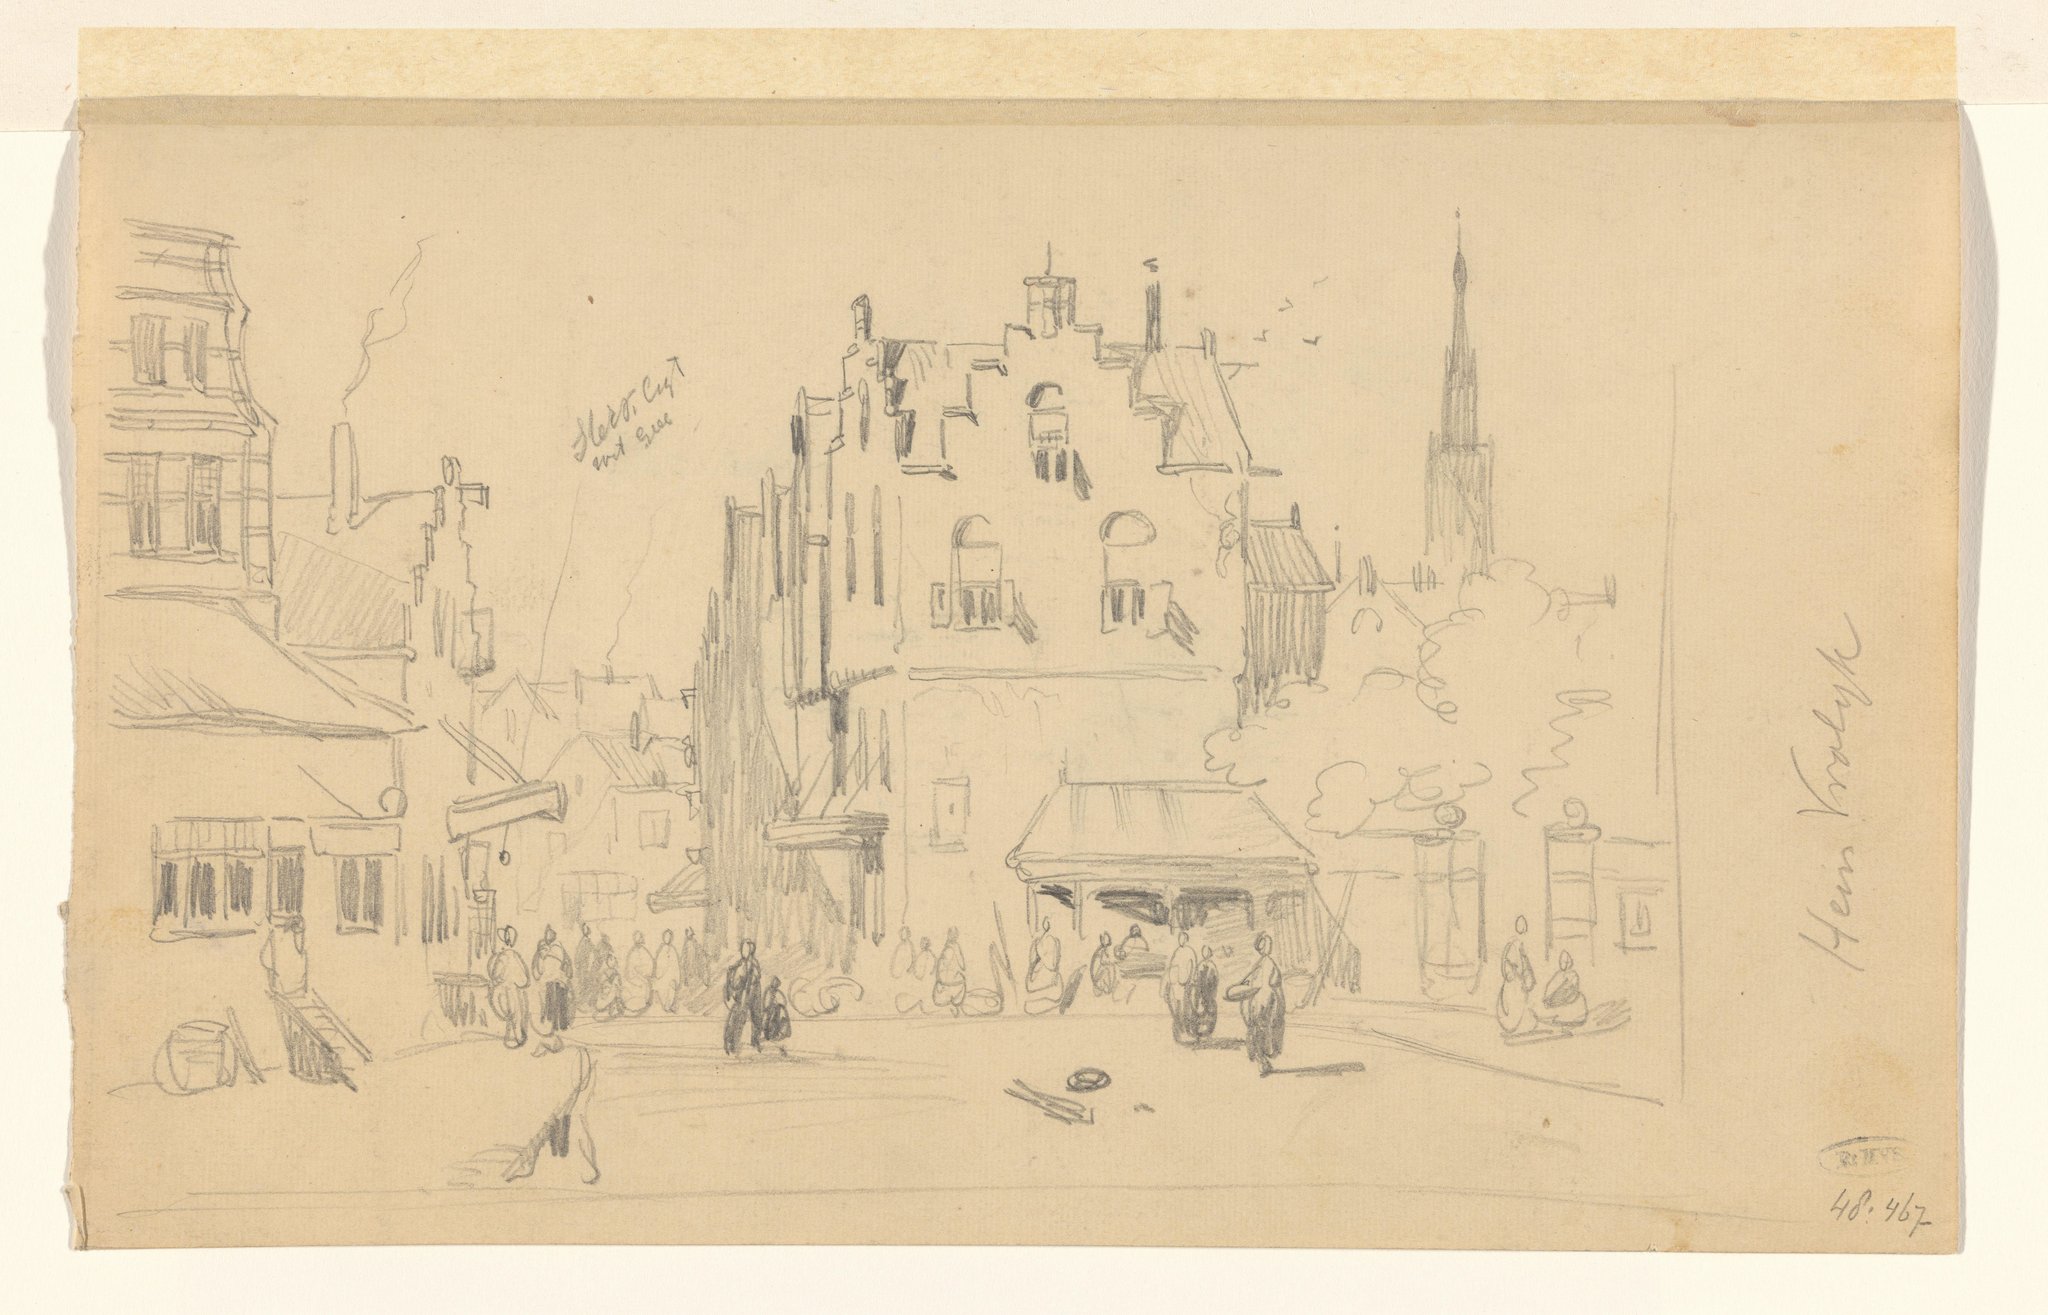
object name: drawing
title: Stadsgezicht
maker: hein vrolijk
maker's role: draughtsman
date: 1800-1900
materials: paper, pencil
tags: street